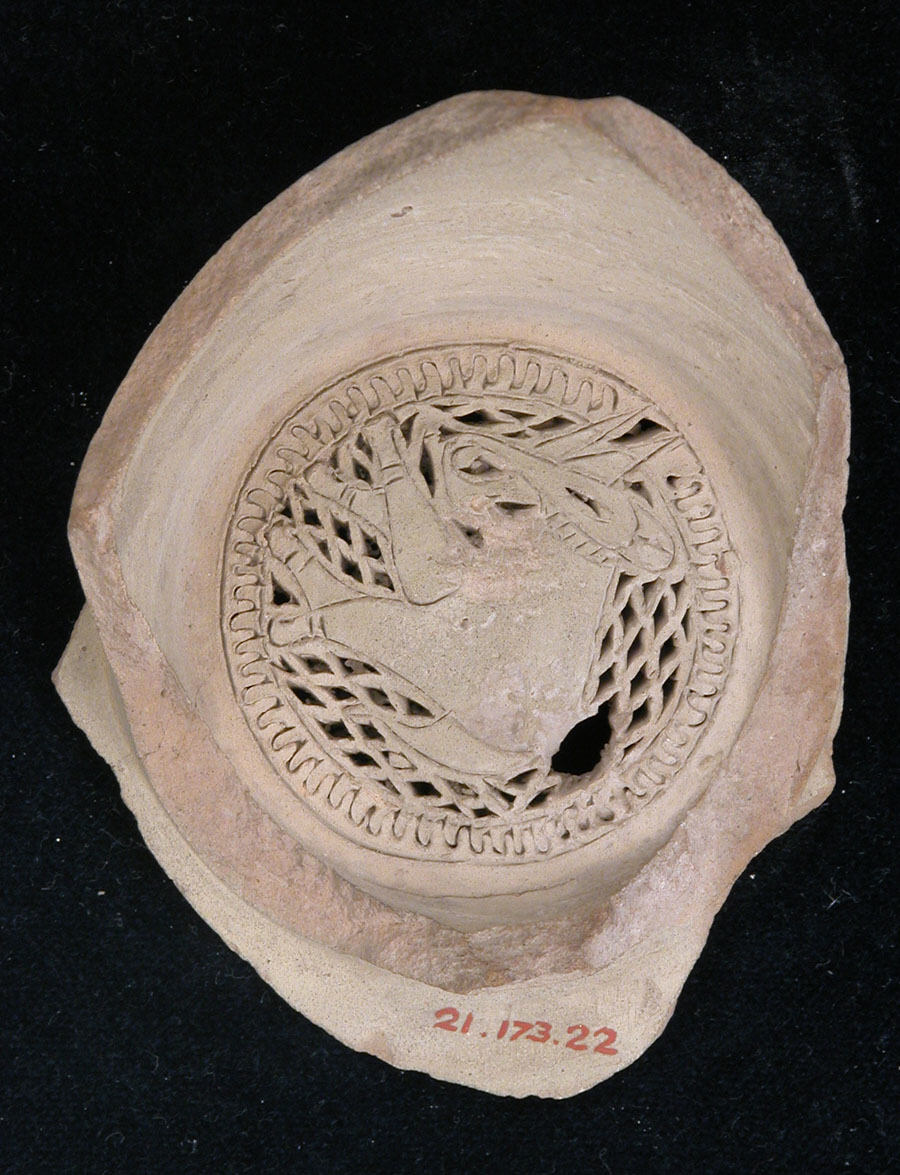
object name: water filter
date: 901-1200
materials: earthenware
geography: egypt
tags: elephants